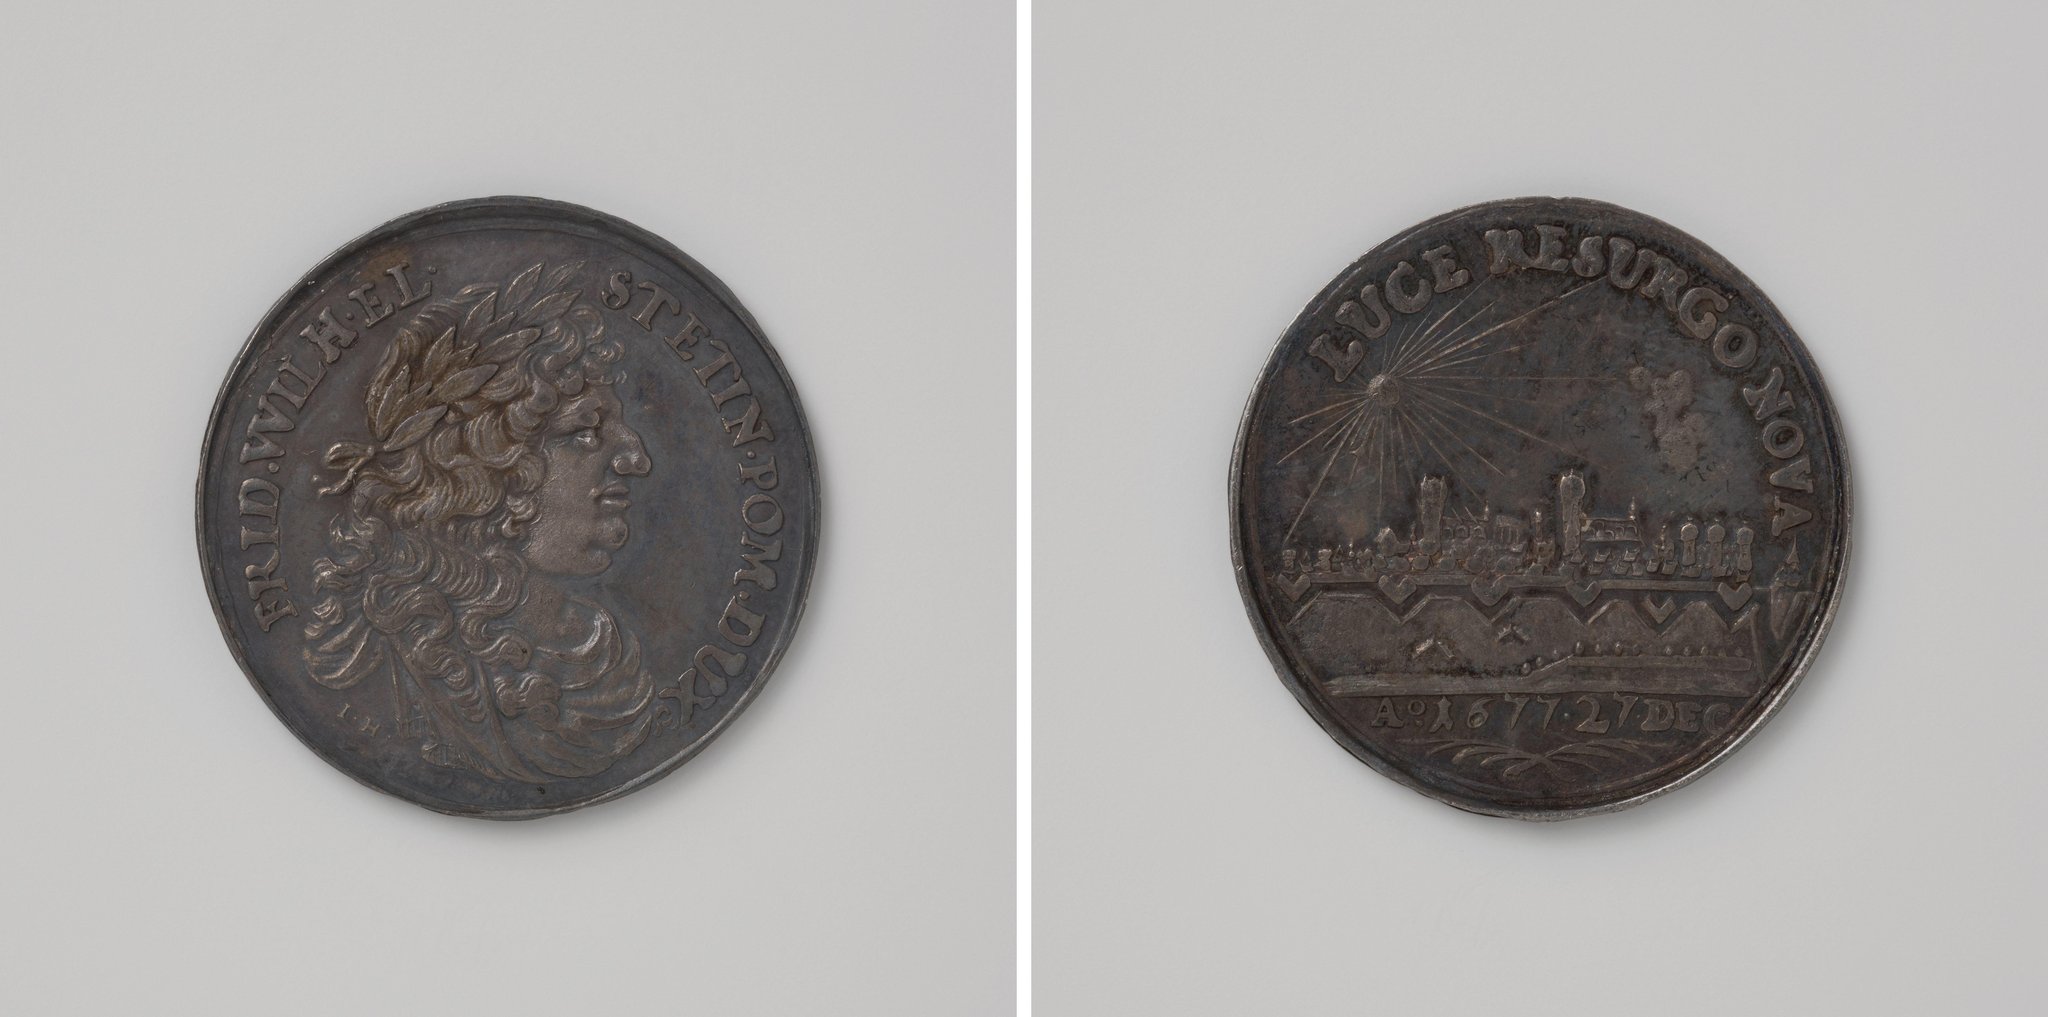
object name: history medal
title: Inhuldiging van keurvorst Frederik Willem van Brandenburg als hertog van Pommeren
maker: johann höhn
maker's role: medailleur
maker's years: 1637-1693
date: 1678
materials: silver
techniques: striking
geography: danzig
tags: berlin, frederik willem van brandenburg (i), poland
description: Zilveren penning. Voorzijde: borststuk man met lauwerkrans binnen omschrift. Keerzijde: opkomende zon boven stadsgezicht binnen omschrift